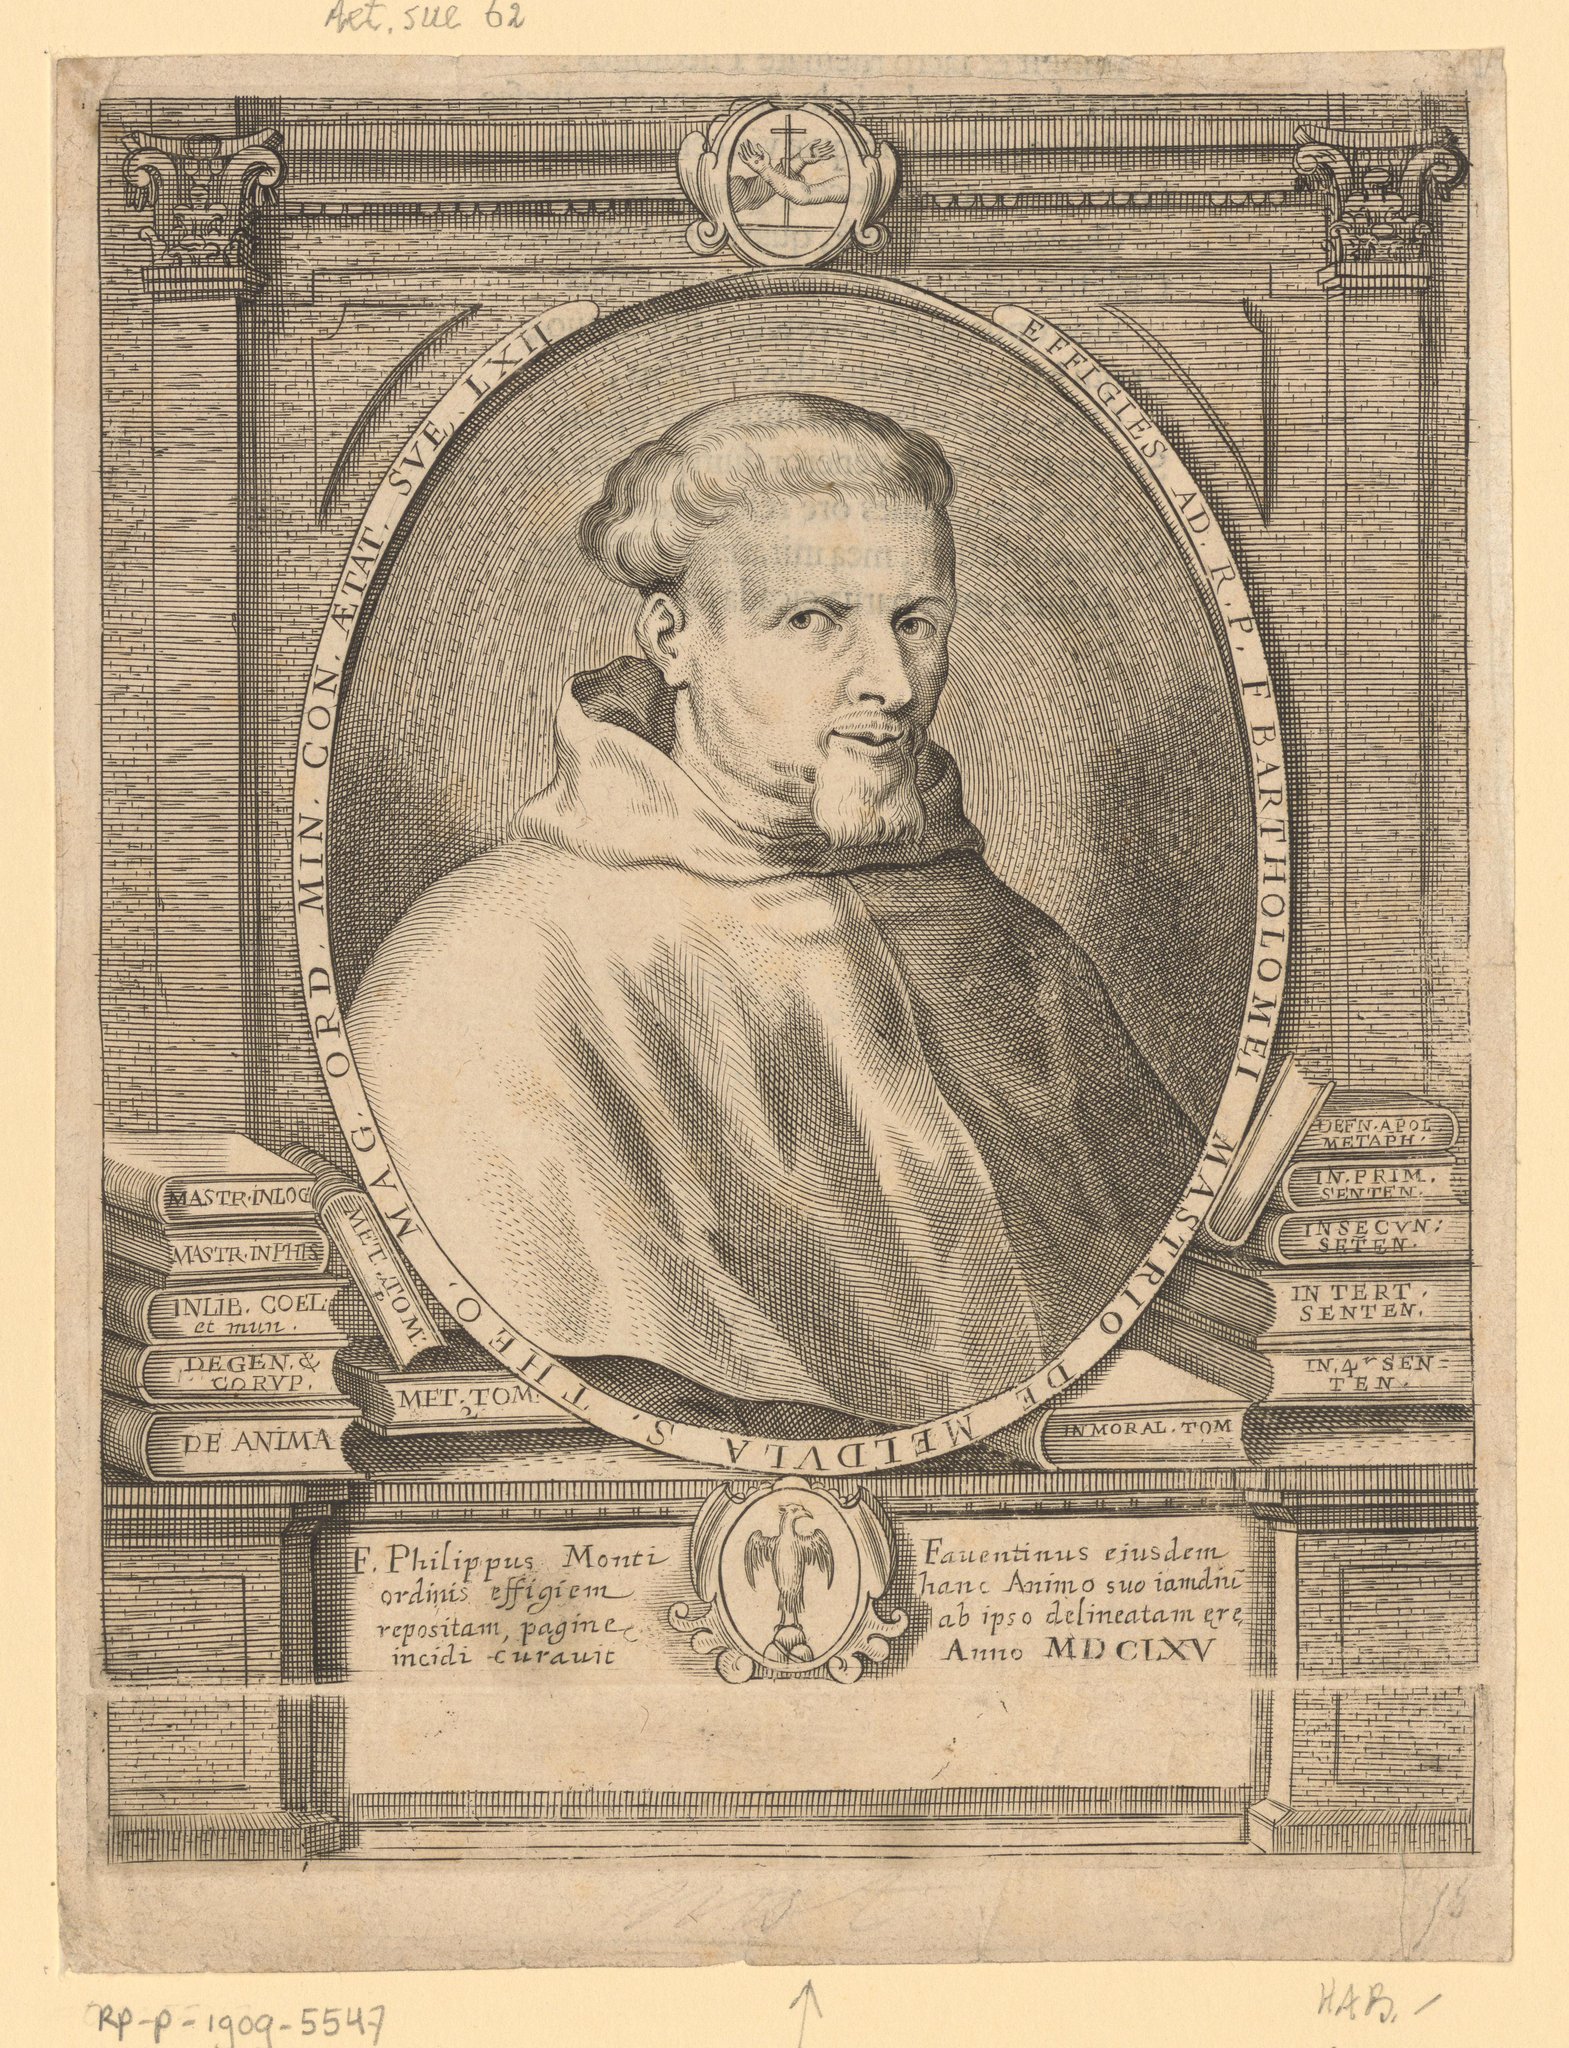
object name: print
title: Portret van Bartolomeo Mastri op 62-jarige leeftijd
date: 1665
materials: paper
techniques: engraving, letterpress printing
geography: venice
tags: theologian, ornament ~ medallion, historical persons, book, armorial bearing, heraldry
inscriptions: collector's mark: Lugt 2228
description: Prent uit: Mastri, Bartolomeo. Theologia moralis ad mentem DD. seraphici (...). Venetië: Giovanni Giacomo Hertz, 1671.